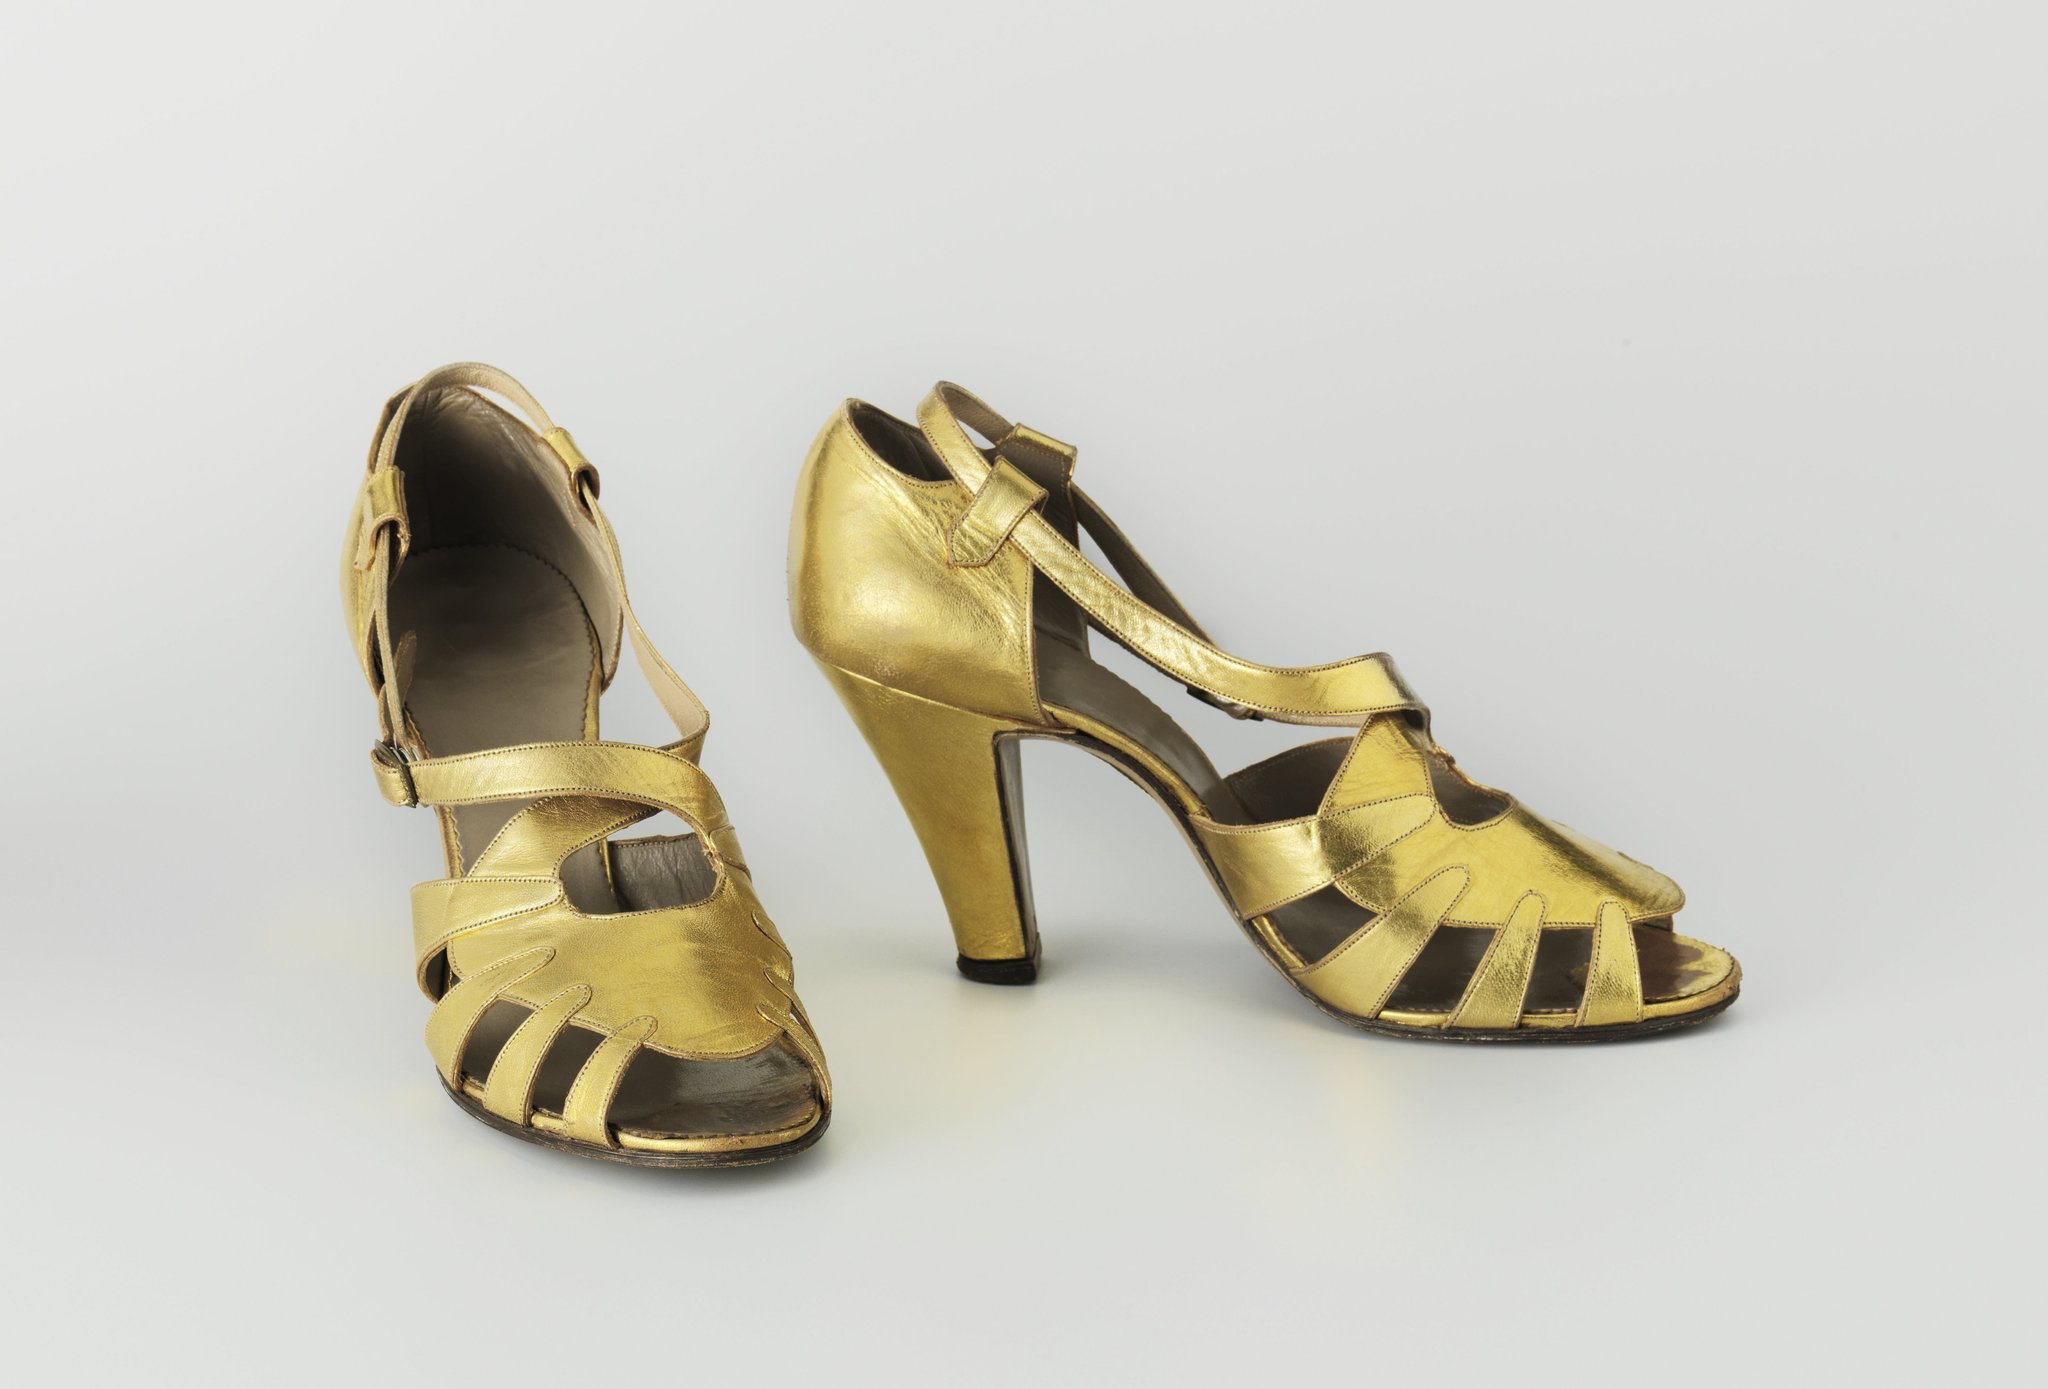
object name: womenswear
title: Damesschoen van verguld leer met open teen met acht tongvormige banden die de zool verbinden met het voorblad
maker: Anonymous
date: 1937-1940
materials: leather, metal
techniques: painting, tanning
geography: netherlands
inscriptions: size: ‘5’, address: ‘KOH-I-NOOR // PAT. // APPO.’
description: Damesschoen of sandaal van verguld leer met open teen. Model: Afgeronde neus, één voorblad en twee achterbladen. De voorkant van de hak loopt in een rechte hoek naar beneden. De zijkant en achterkant van de hak lopen schuin naar binnen waardoor de hak naar onder toe smaller wordt. De hak is bekleed met verguld leer. Acht tongvormige banden verbinden de zool met het voorblad. Het voorblad volgt de vorm van de zool en eindigt bij de wreef in twee banden die kruislings uitlopen in een enkelband. Door het kruisen van de banden ontstaat er een gat midden op de voorvoet. Door een lipje die vanaf het zijblad omgeslagen op het zijblad is bevestigd ontstaat een opening waar de enkelband doorheen loopt. Aan de linkerkant van de schoen is het enkelband door een metalen drukknoop met elkaar verbonden. Leren achterlapje met drie spijkers aan de hak vastgeslagen en leren zool. Zijbladen en voorblad gevoerd met leverkleurig leer. De binnenzool is van leverkleurig leer. Versiering: Op de drukknoop is over de enkelband een metalen bewerkte gesp bevestigd.